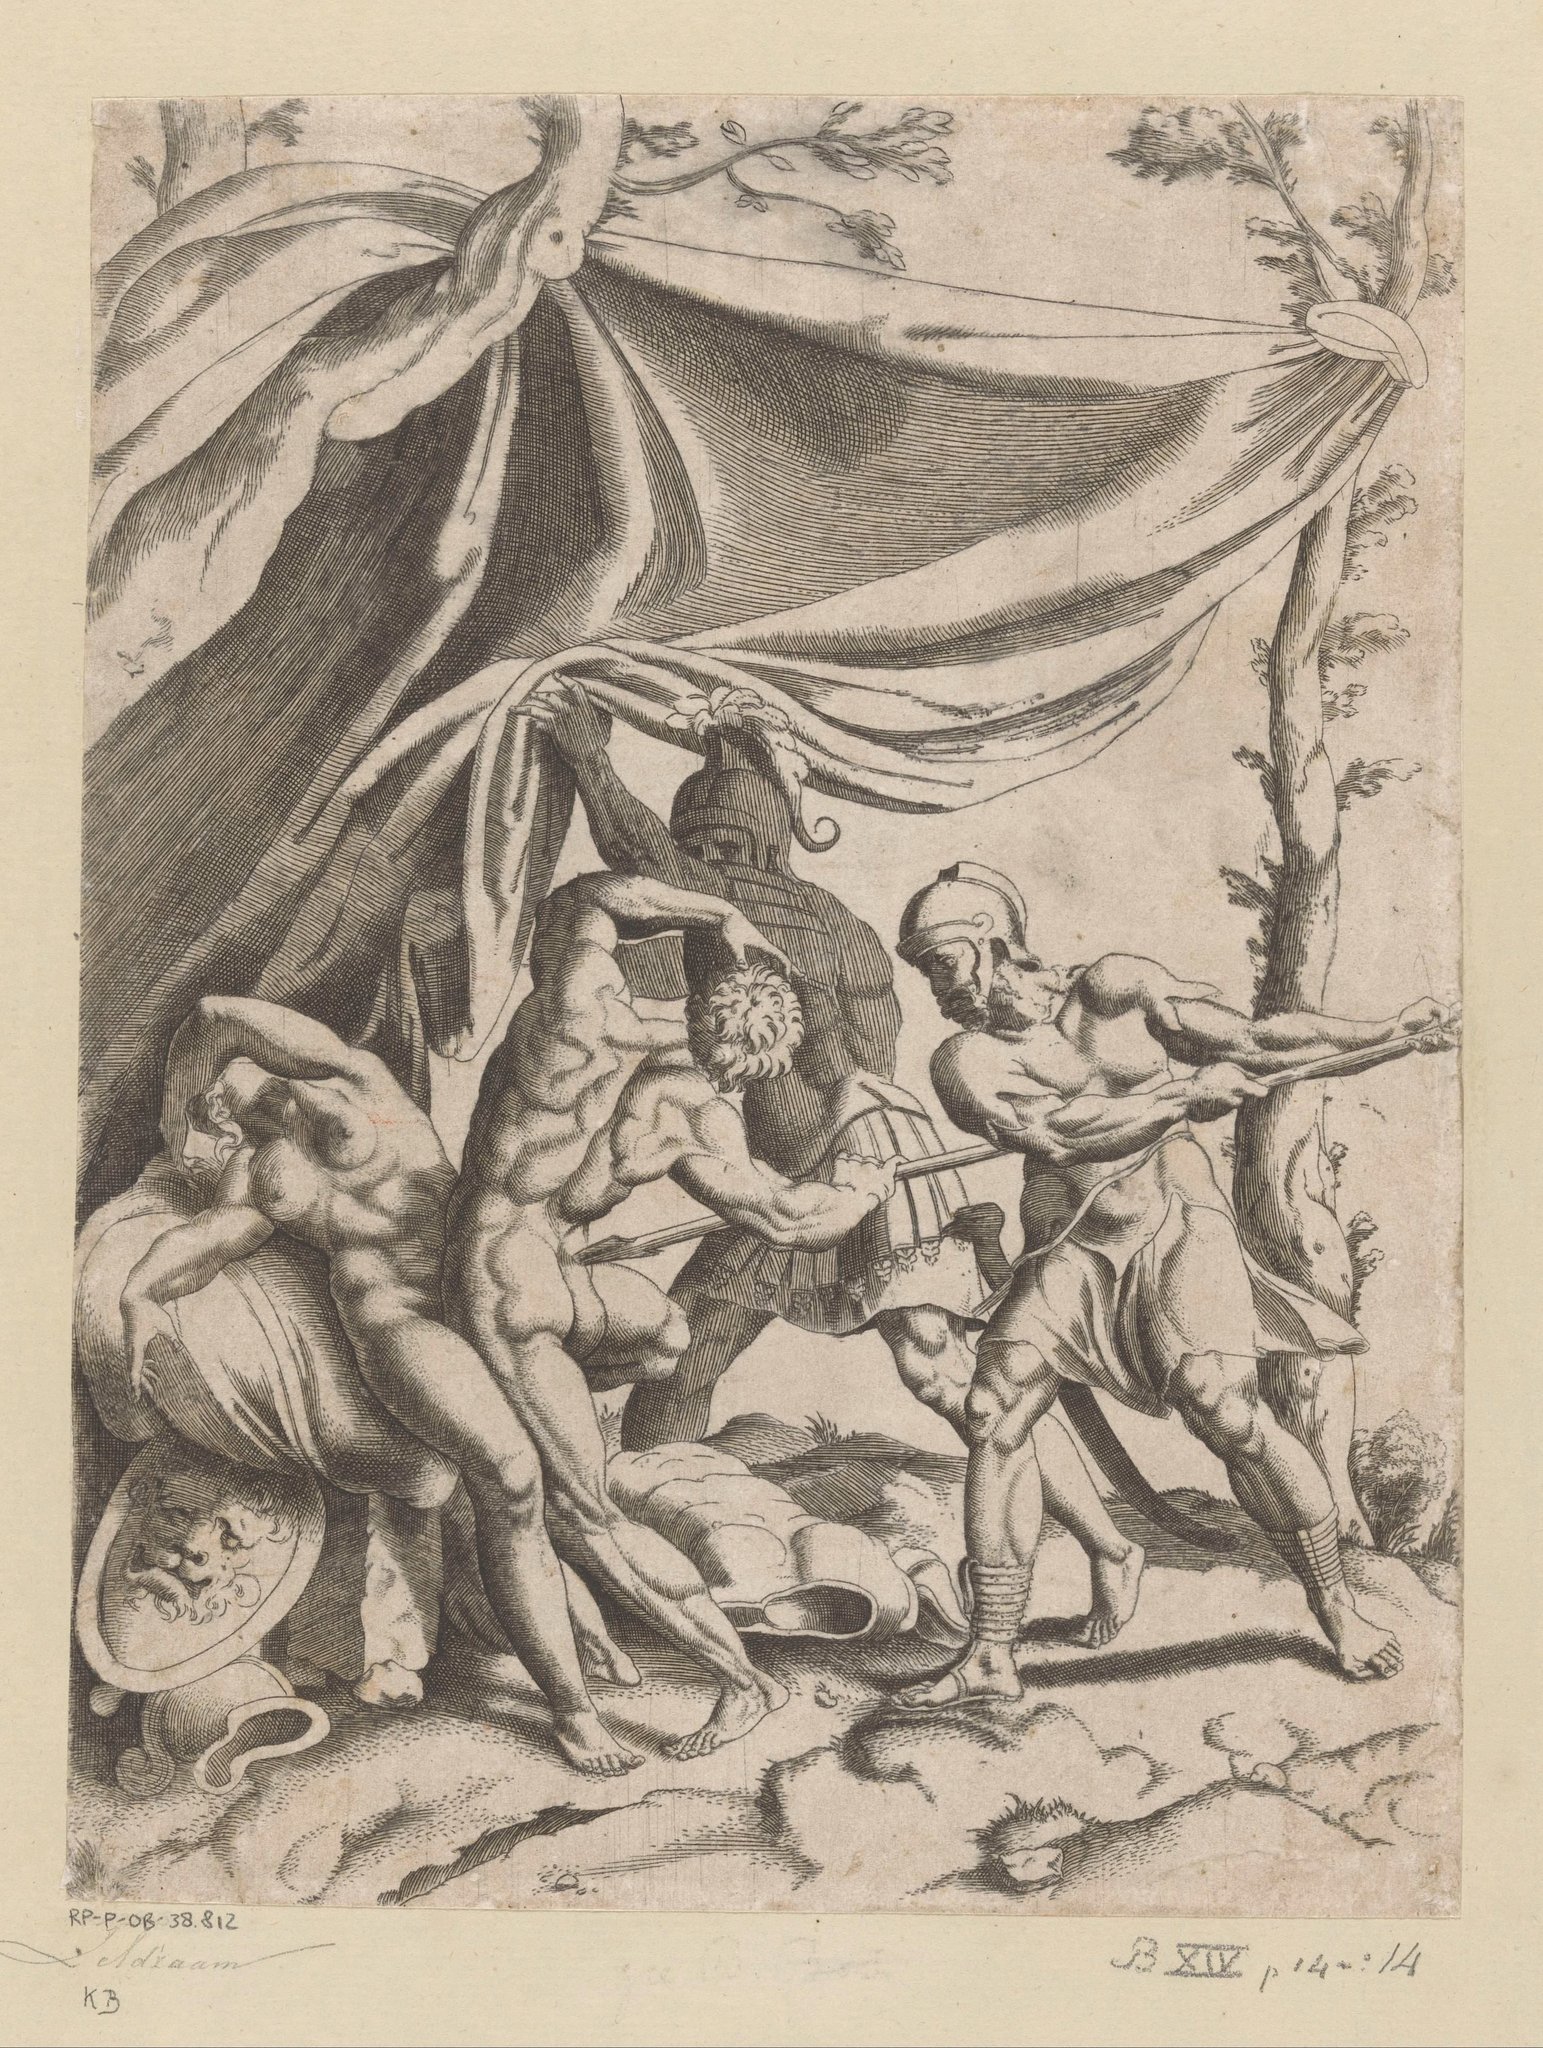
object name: print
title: Pinechas doodt Zimri en Kozbi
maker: Anonymous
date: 1500-1599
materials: paper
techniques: engraving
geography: italy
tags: phinehas, eleazar's son, follows zimri and cozbi and drives his spear through both of them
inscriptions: collector's mark: Lugt 12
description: De Israëliet Zimri nam de Midjanitische vrouw Kozbi mee naar zijn tent. De hogepriester Pinechas heeft hen gevolgd naar de tent en doorboort beiden met een speer. Een metgezel van Pinechas houdt het tentdoek omhoog.